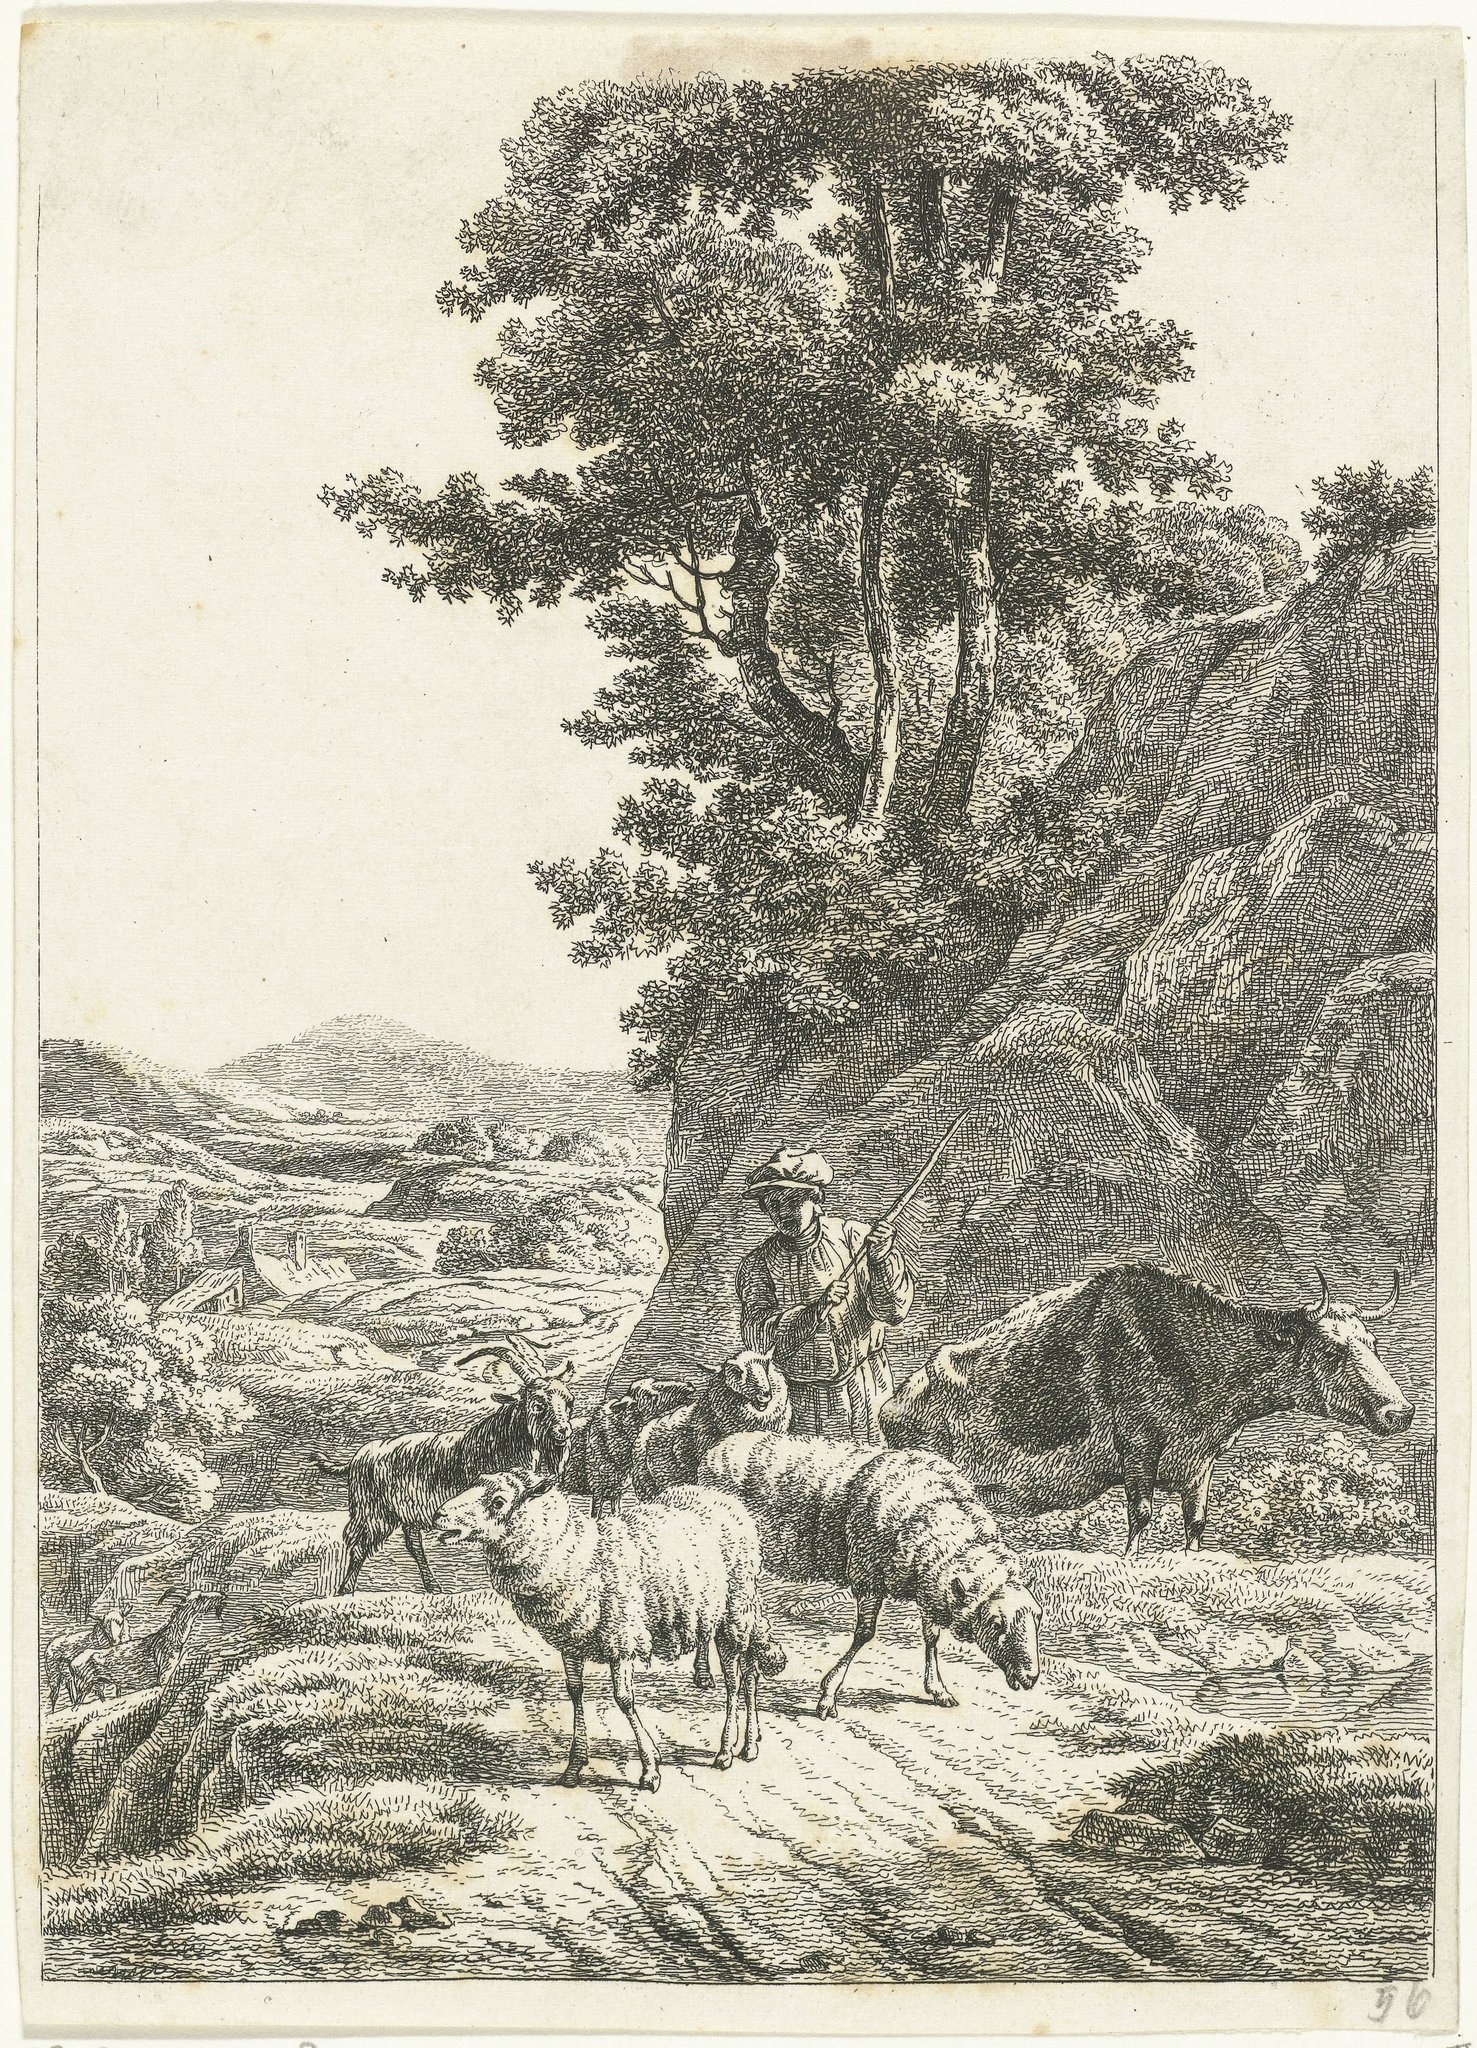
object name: print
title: Herder met kudde op bergpad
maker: frédéric théodore faber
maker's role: print maker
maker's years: 1782-1844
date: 1817-1828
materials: paper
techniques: etching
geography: brussels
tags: herding, herdsman, herdswoman, shepherd, shepherdess, cowherd, etc.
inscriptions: collector's mark: Lugt 1485, collector's mark: Lugt 2228